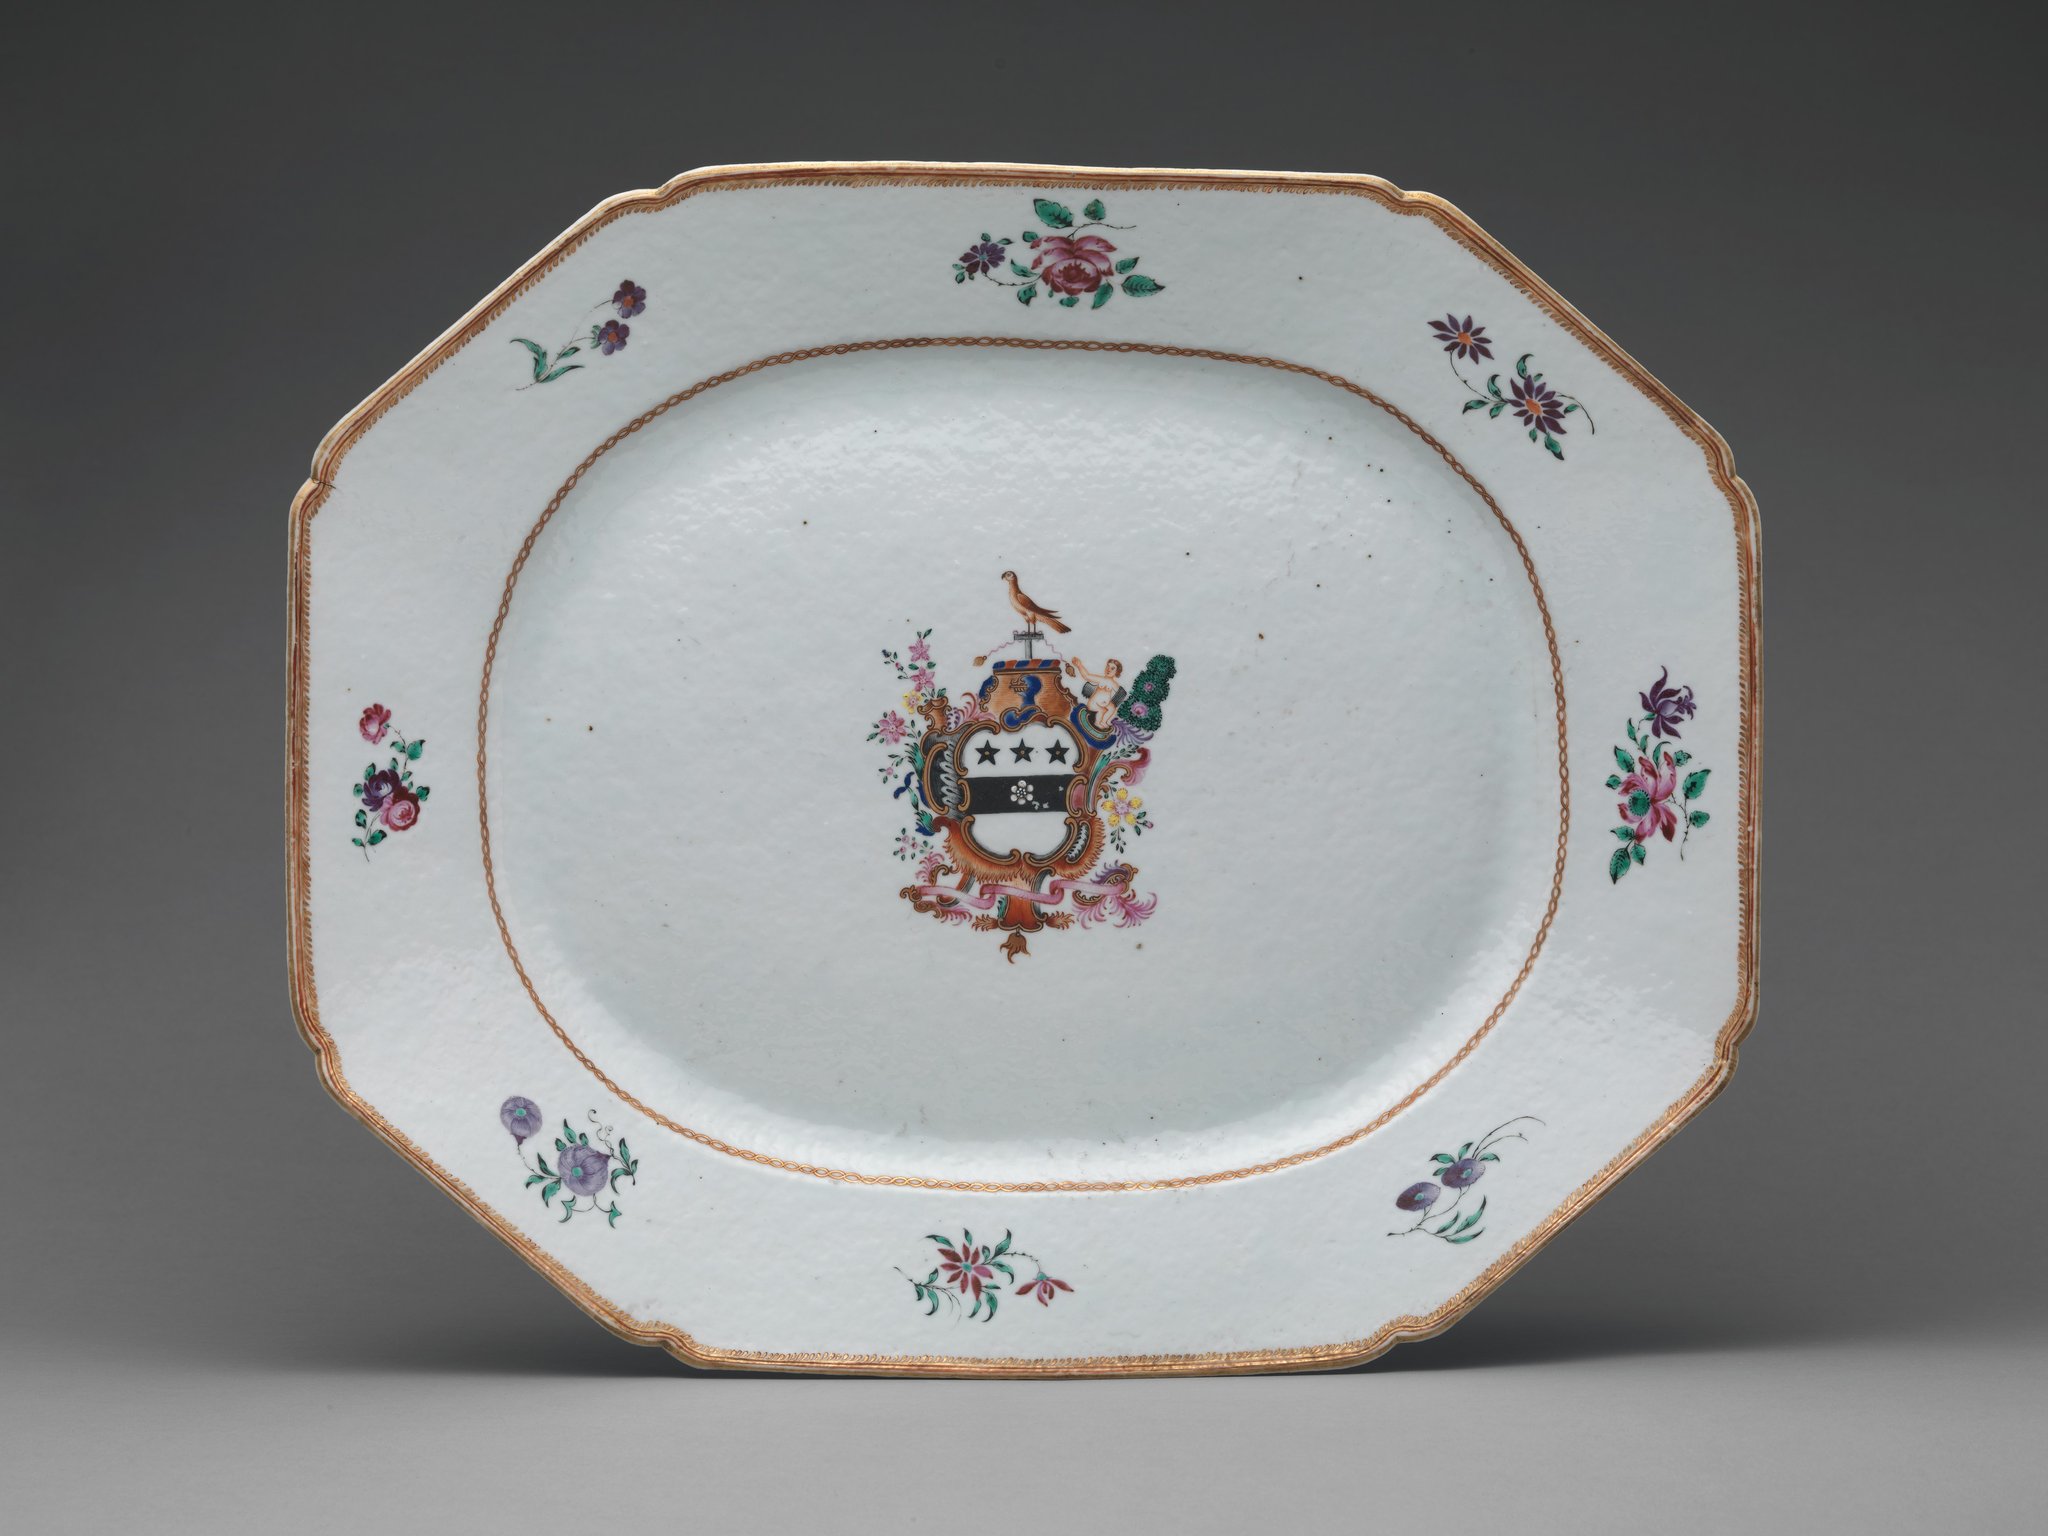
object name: platter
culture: chinese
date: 1785-1790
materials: porcelain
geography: china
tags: birds,coat of arms